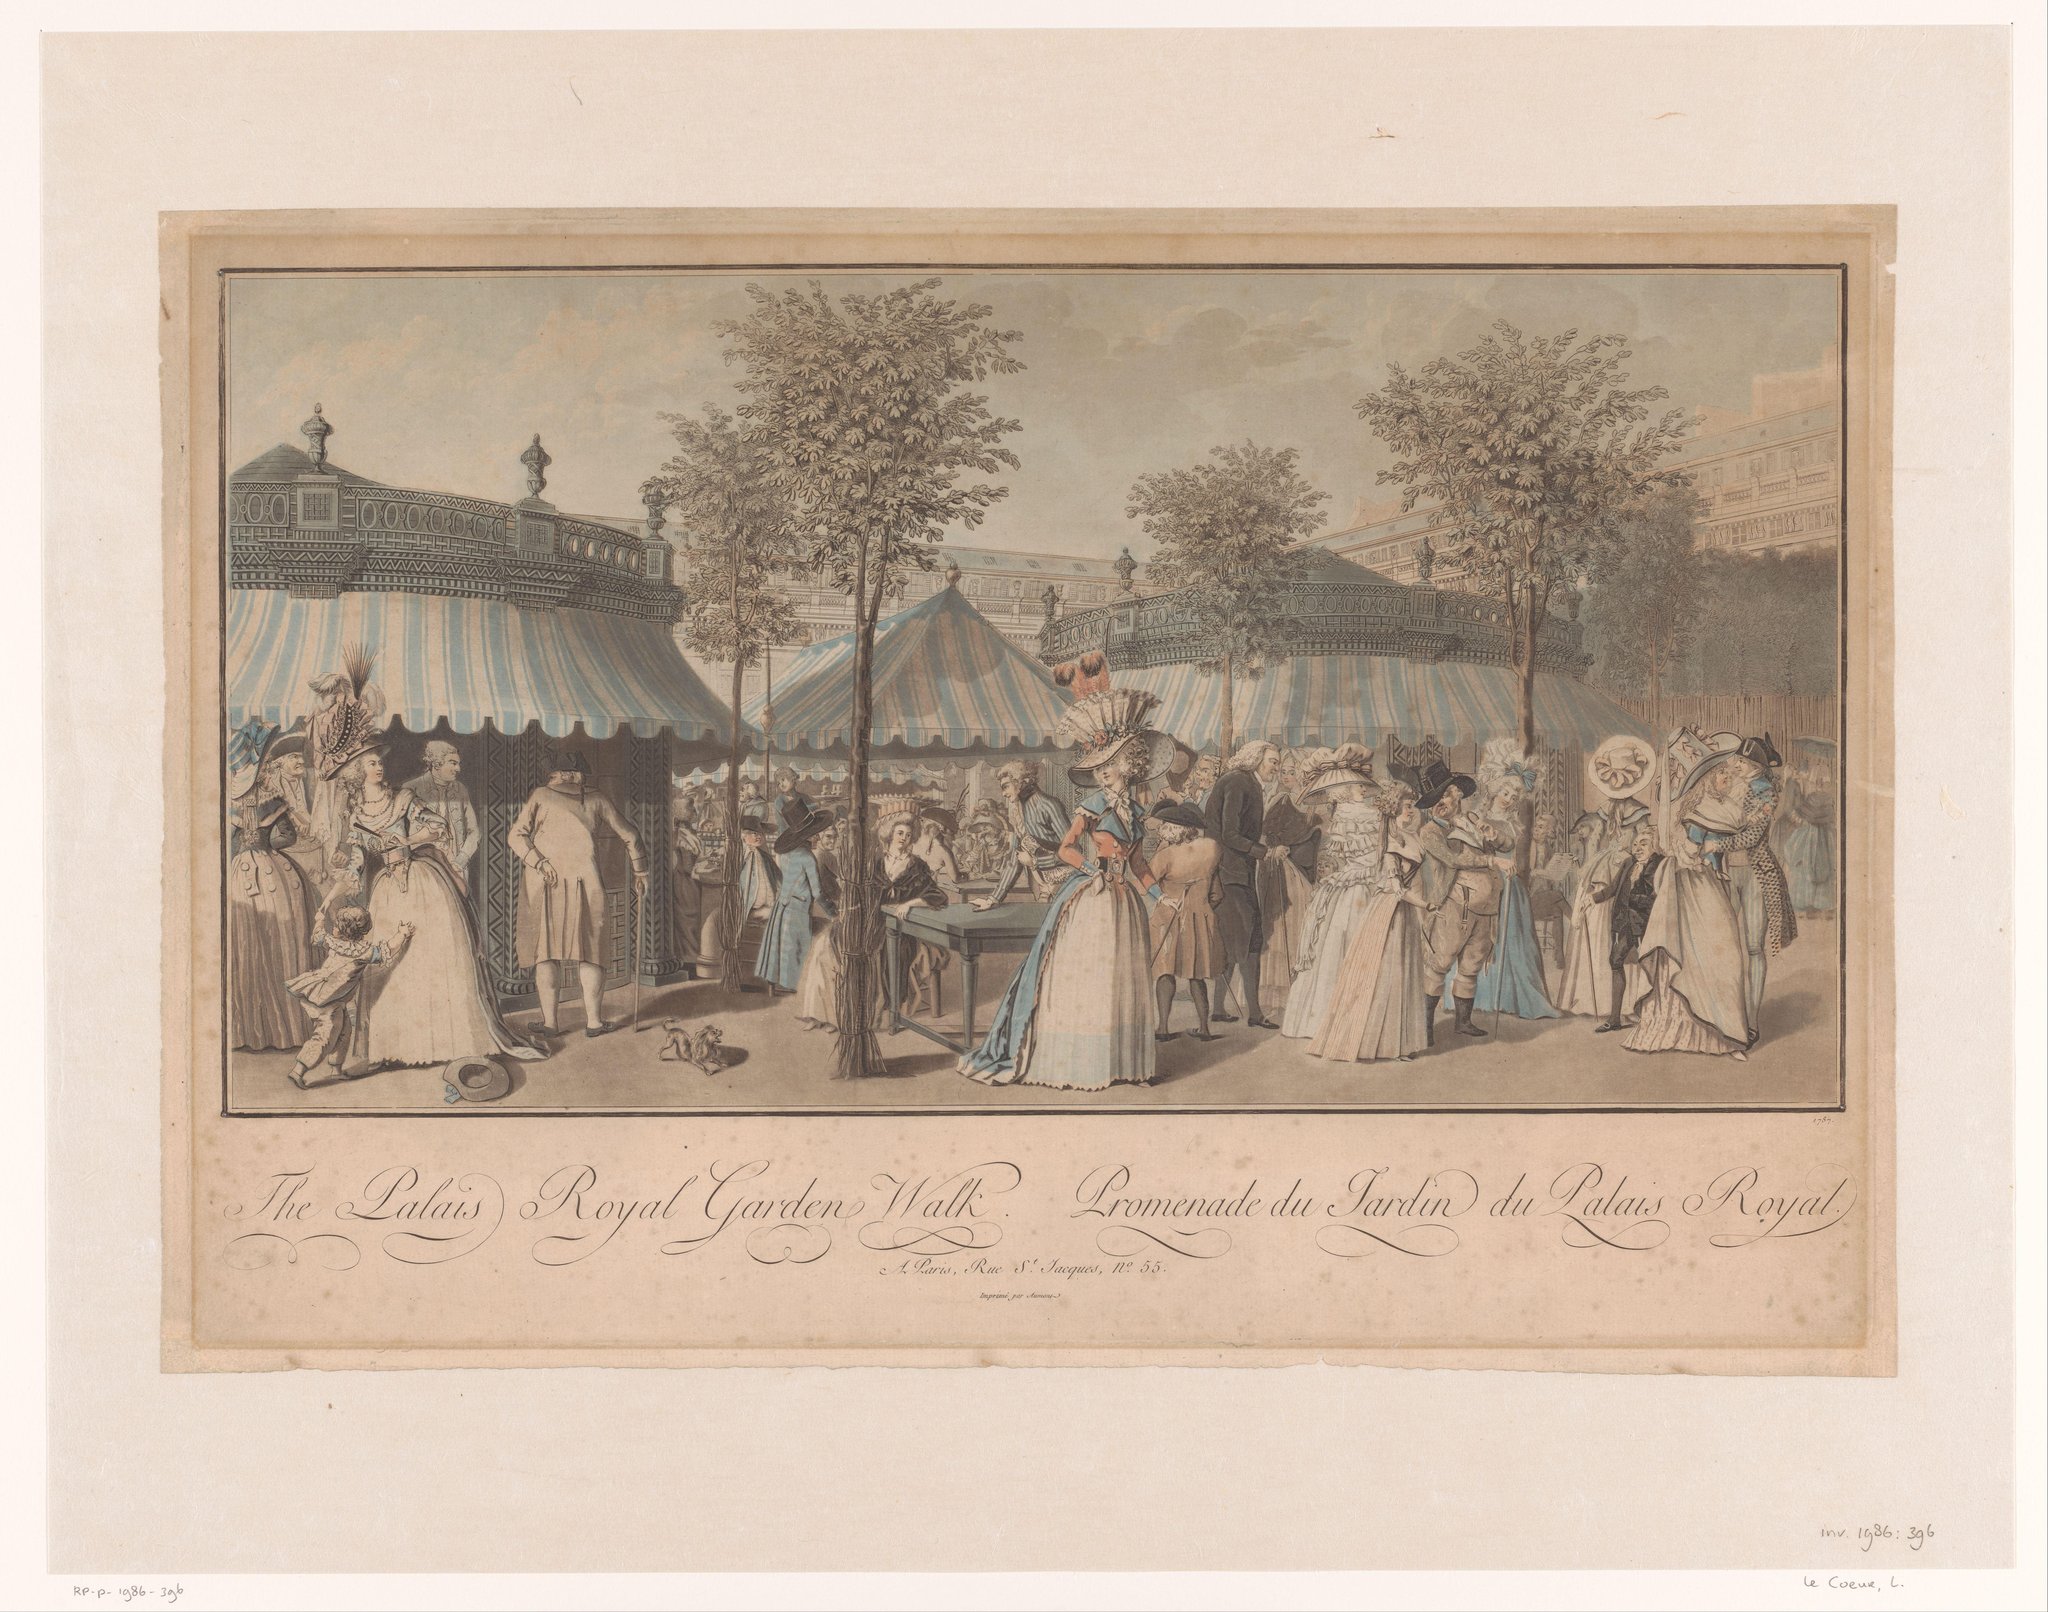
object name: print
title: Strolling in the Gardens of the Palais Royal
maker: louis lecoeur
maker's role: print maker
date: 1787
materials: paper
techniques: etching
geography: france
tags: dress, gown: walking dress (+ women's clothes), dress, gown: redingote (+ women's clothes), coat (+ men's clothes), head-gear: hat (+ men's clothes), head-gear: hat (+ women's clothes), neck-gear ~ clothing (with name) (+ women's clothes), public gardens, park, paris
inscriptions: address: ‘A Paris, Rue Saint-Jacques No. 45’, watermark: ‘D. Tamizier’, collector's mark: Lugt 2228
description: During the 1780s the garden of the Palais Royal was a popular spot to take a stroll and show off the latest must-haves. Refreshments were served in the pavilions. Though the neighbourhood did not have a good reputation in the late 18th century (prostitution was rife), the Palais Royal managed to attract both native Parisians and tourists. A visit there was recommended in practically every guidebook.